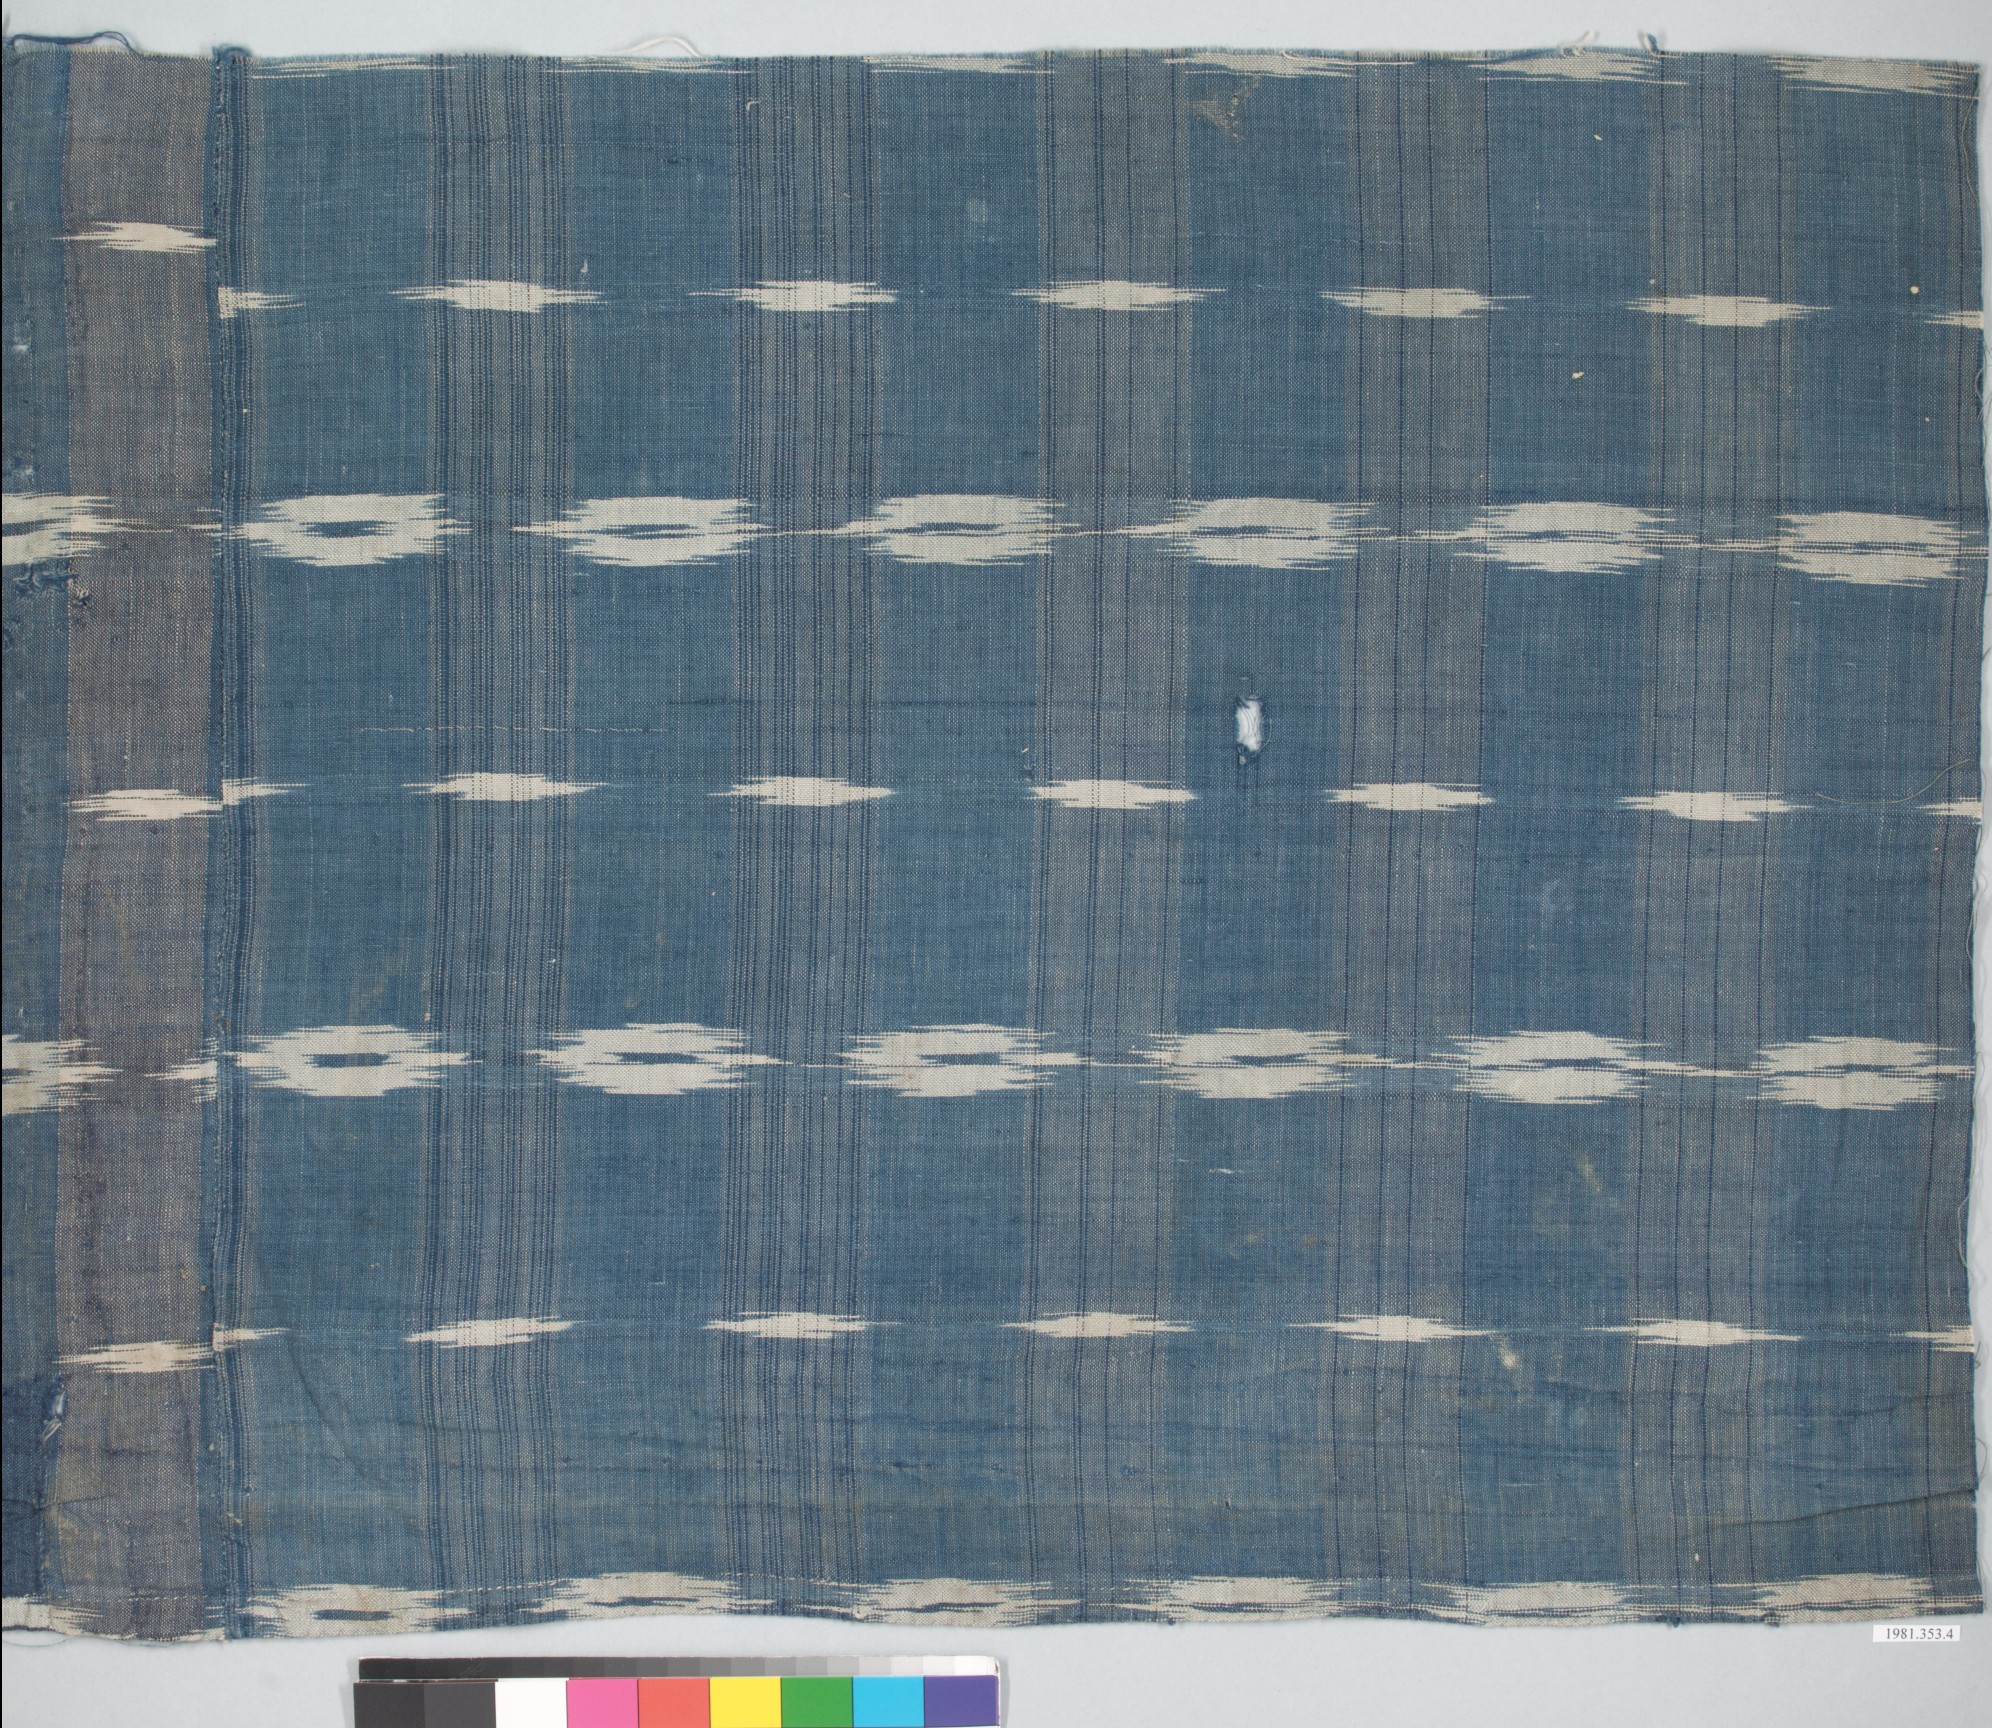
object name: piece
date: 1701-1800